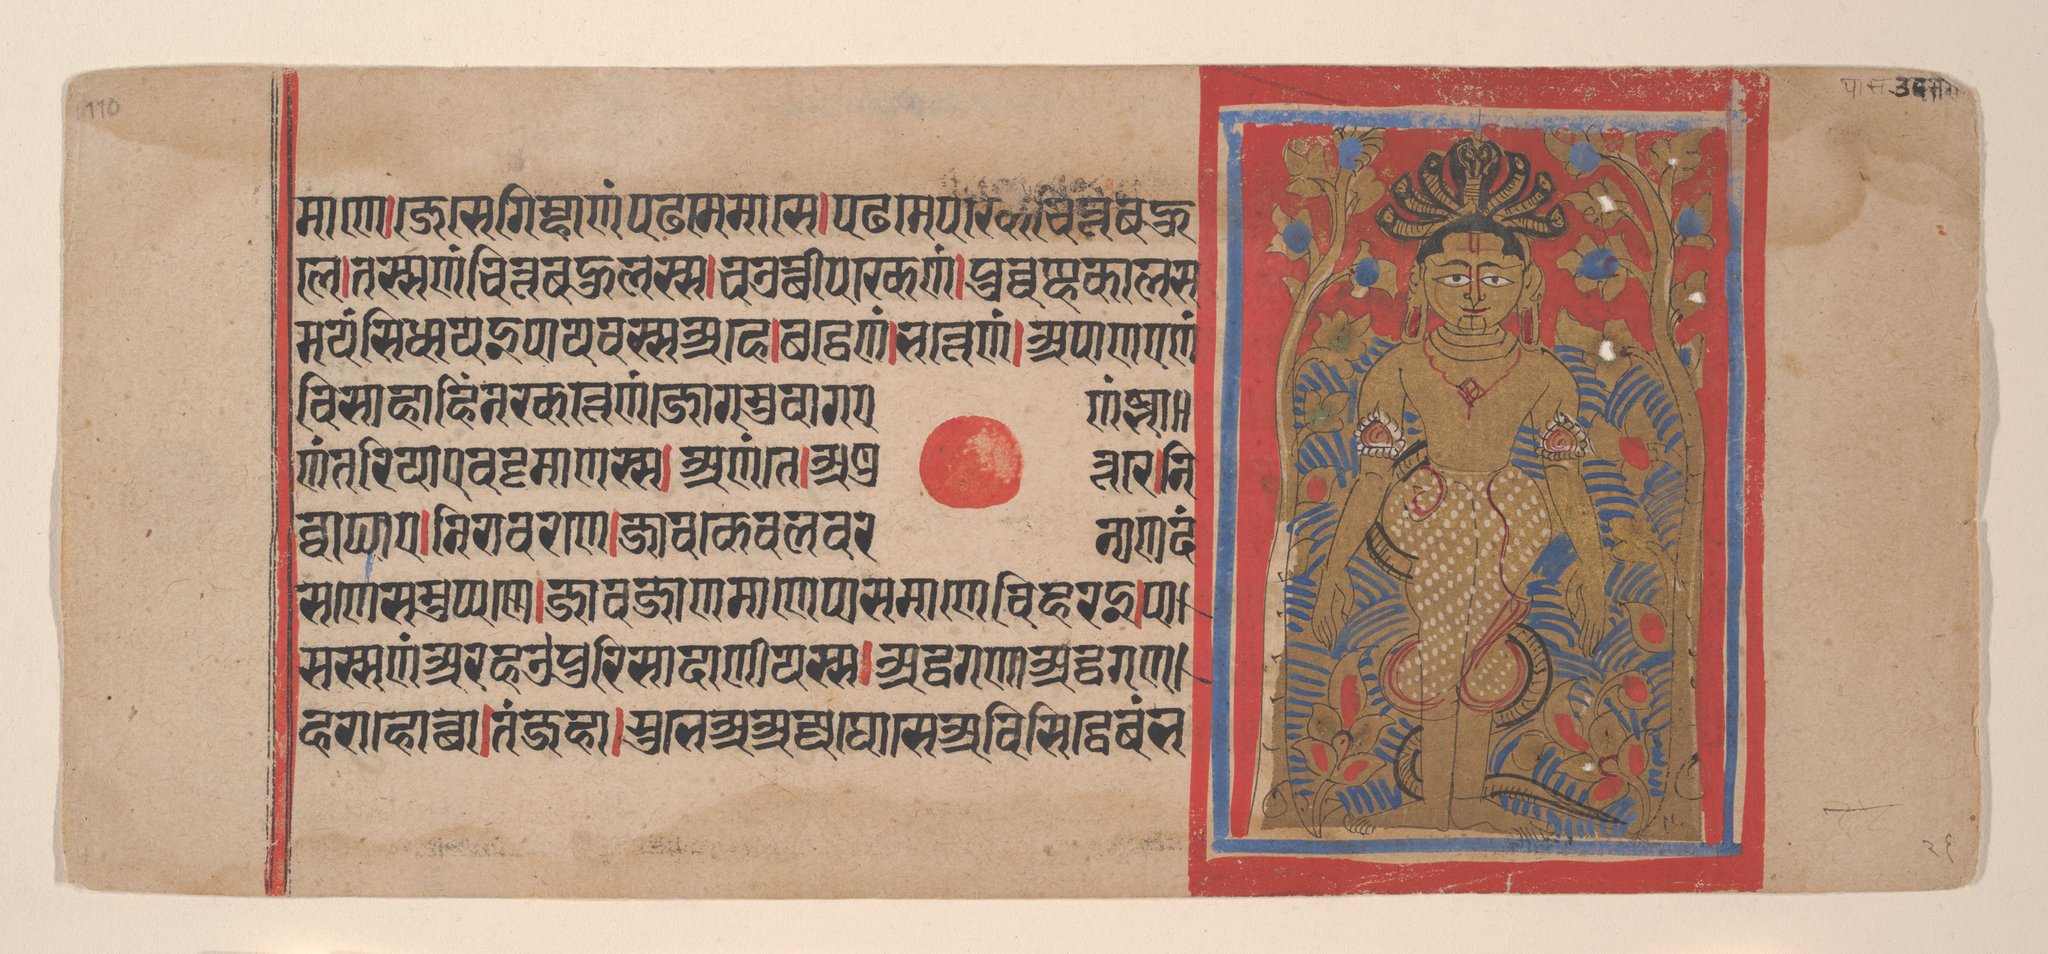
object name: folio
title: Parsvanatha's Austerities: Folio from a Kalpasutra Manuscript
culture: indian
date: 1401-1500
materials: gold, ink, paper, watercolor